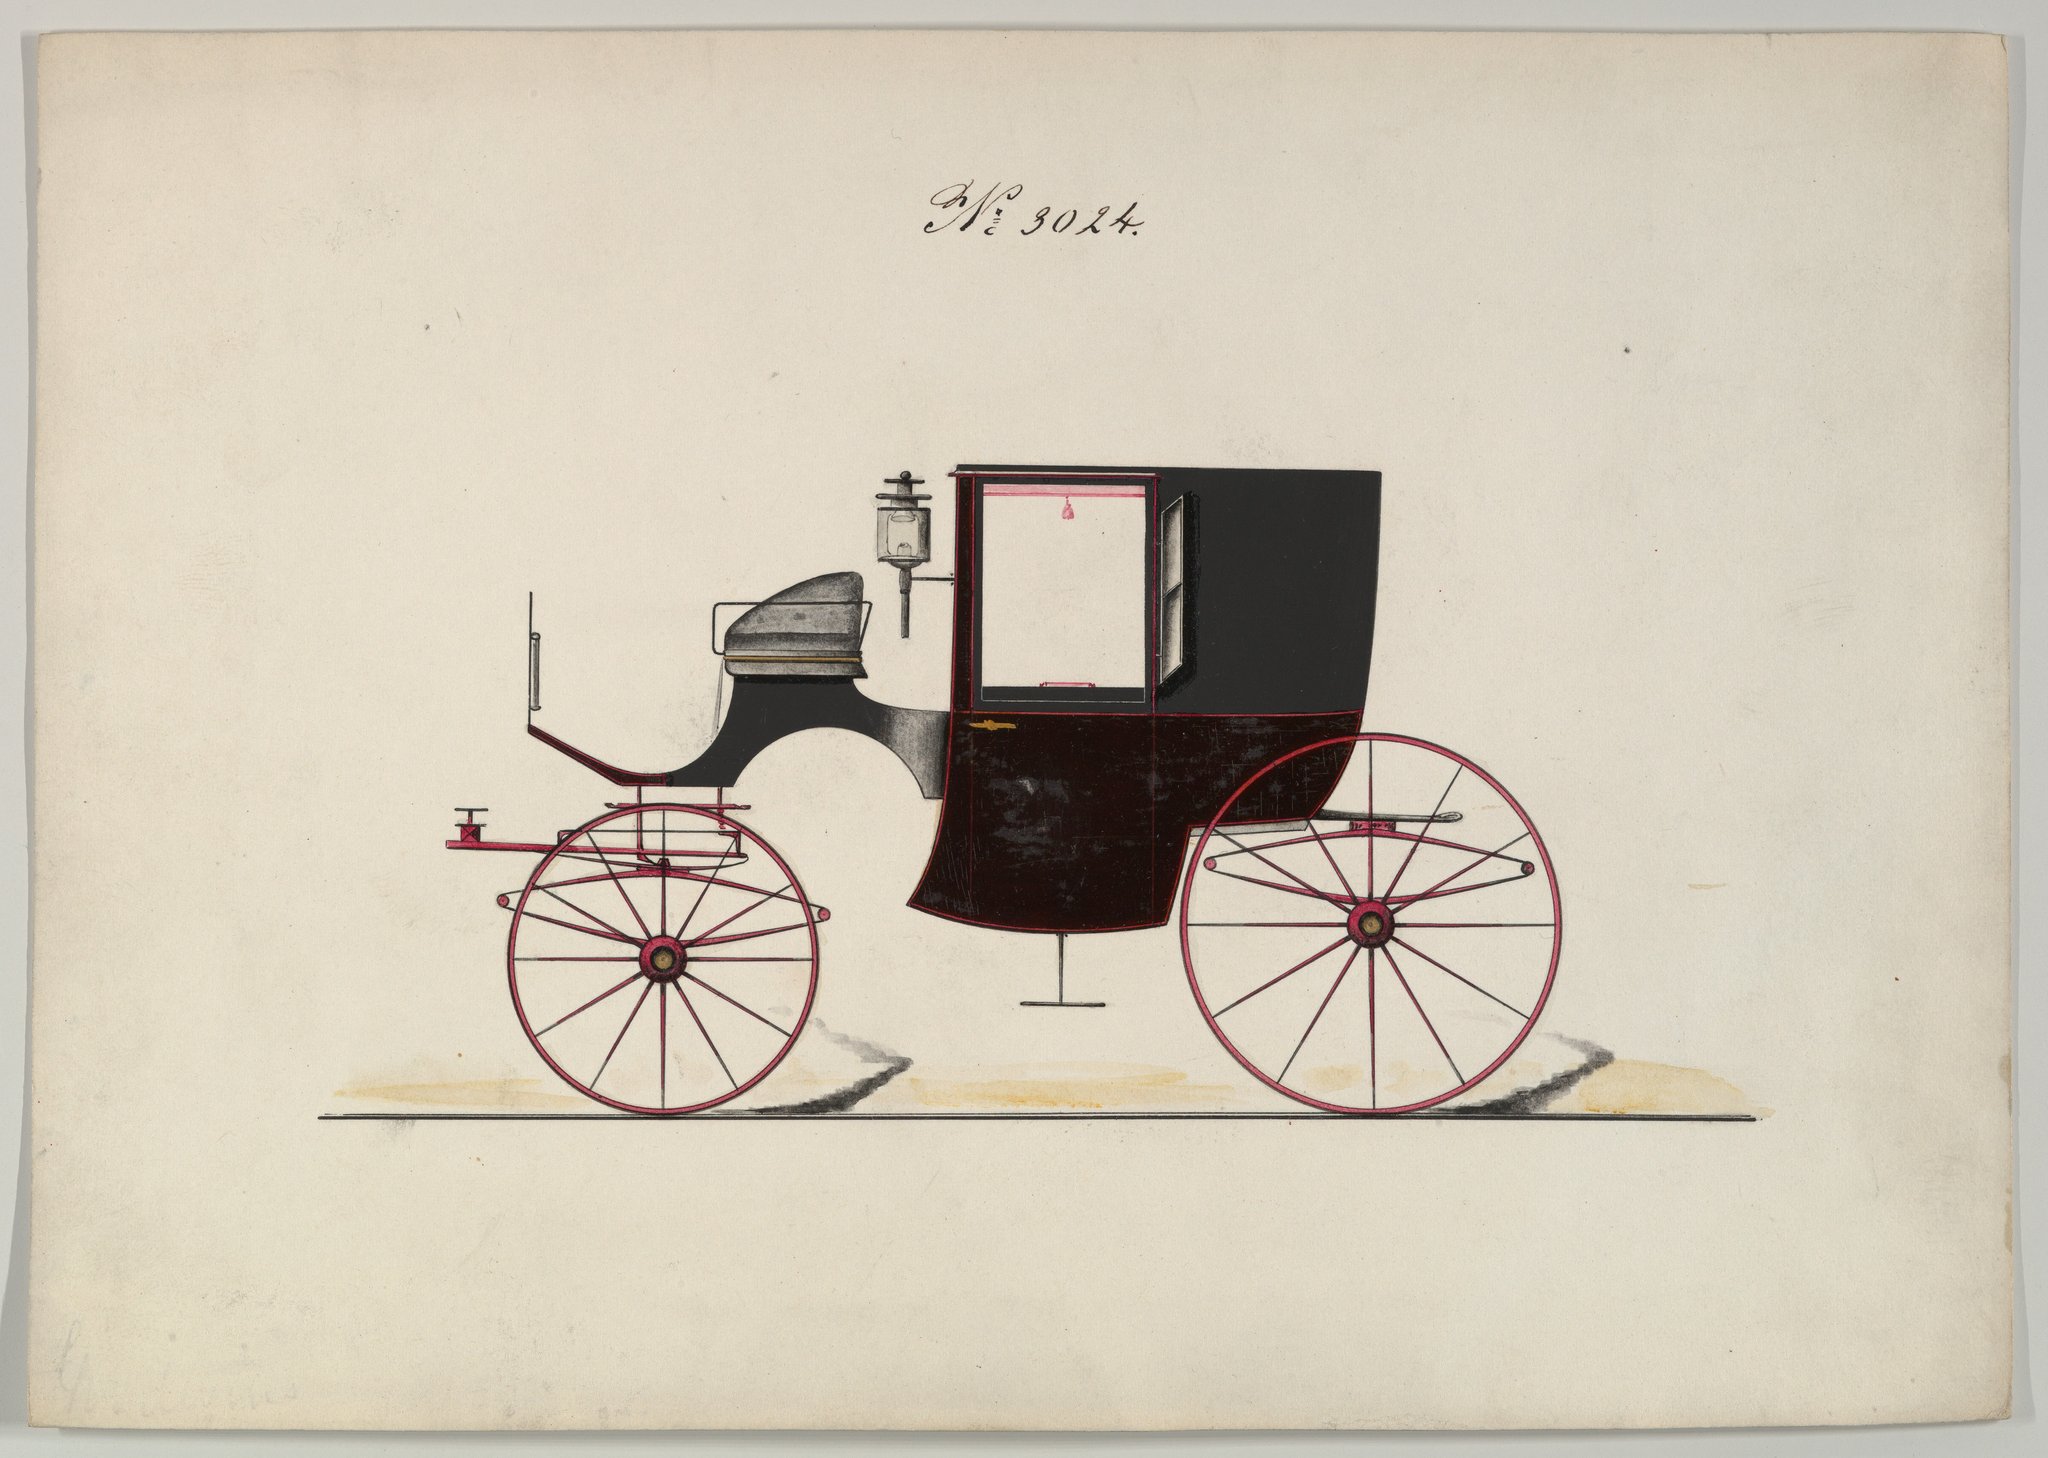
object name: drawing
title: Brougham #3024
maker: brewster & co.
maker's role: manufacturer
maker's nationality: american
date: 1874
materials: gouache, gum arabic, ink, watercolor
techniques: pen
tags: carriages